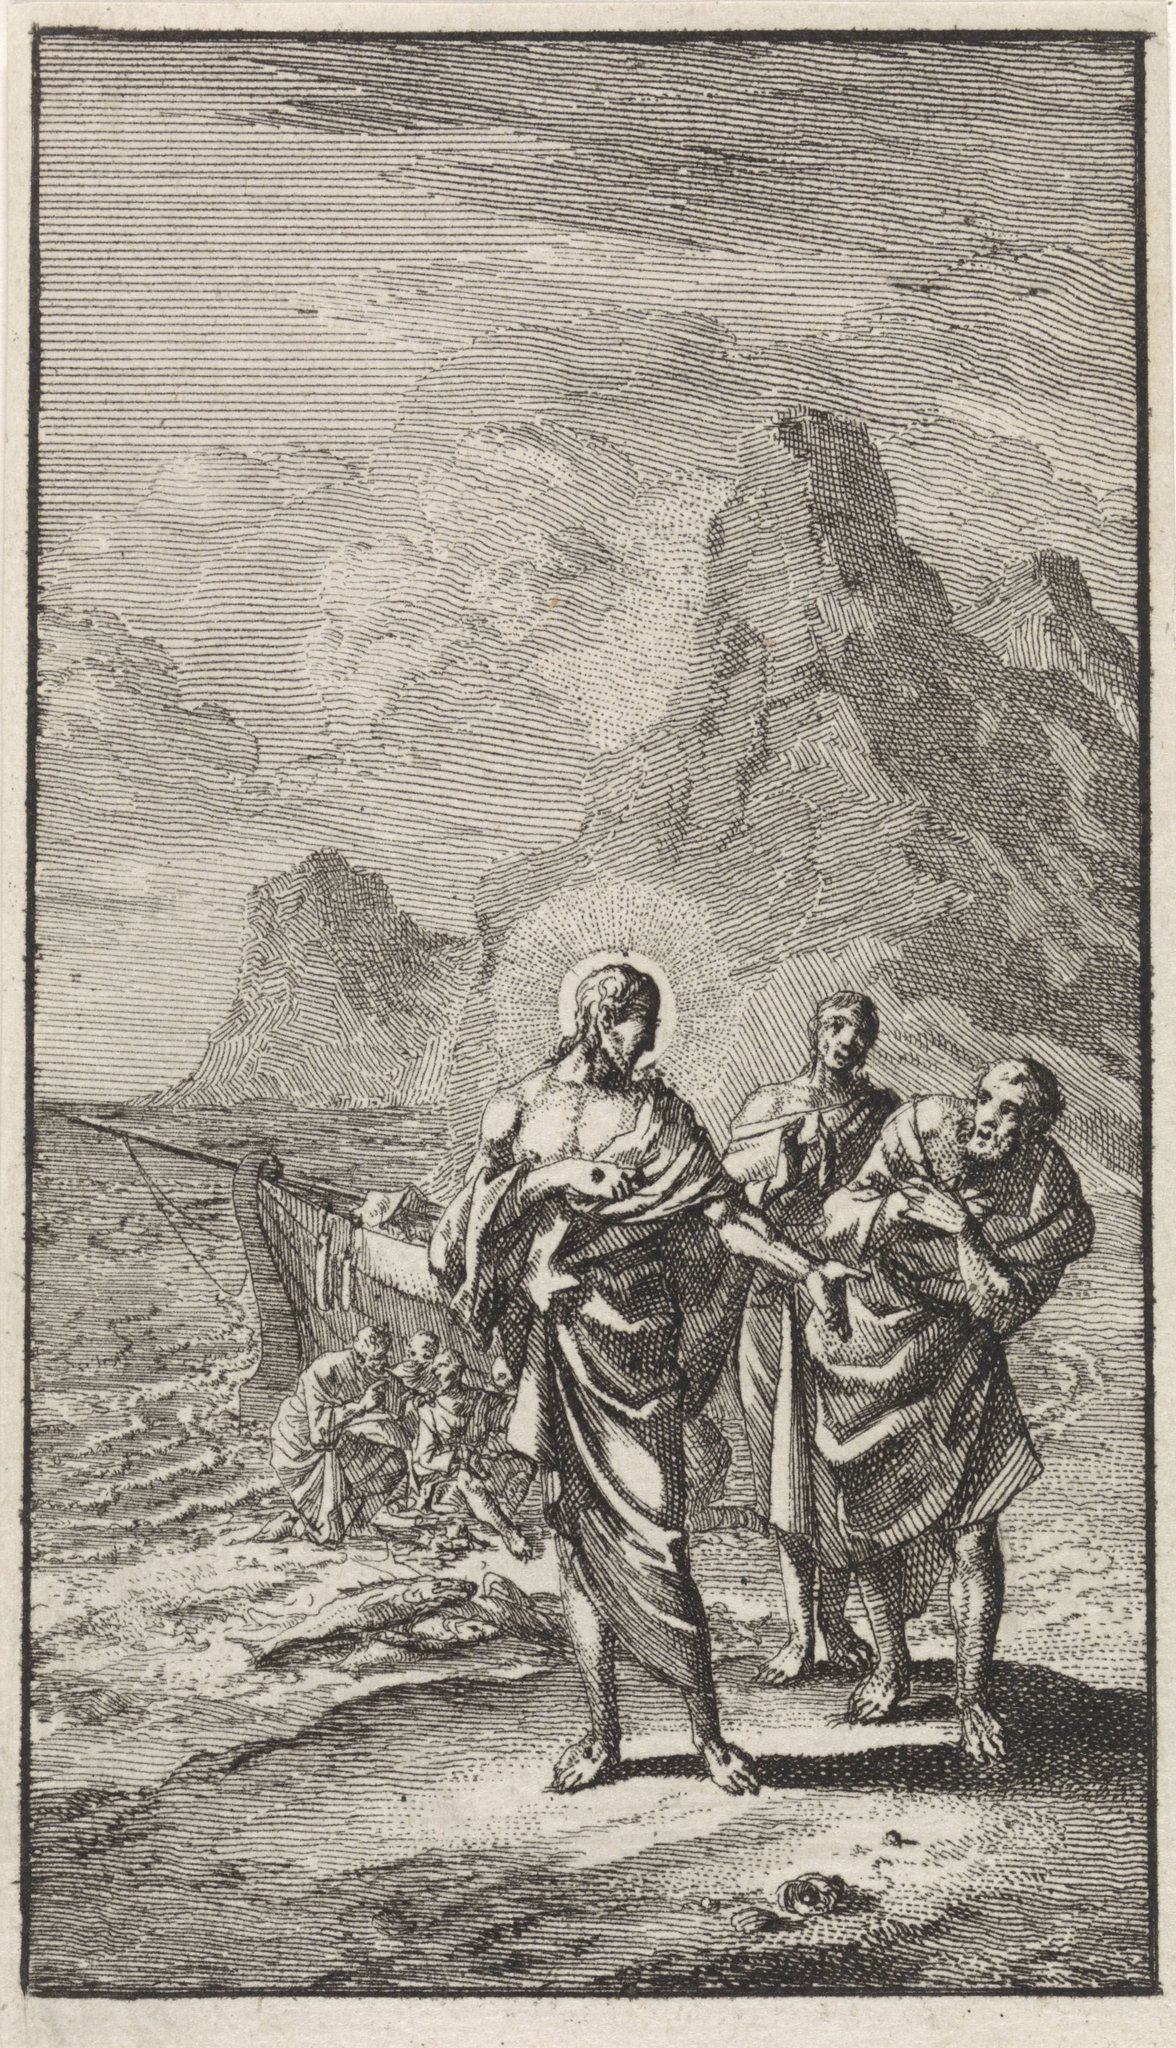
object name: print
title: Christus verschijnt bij het Meer van Galilea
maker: jan luyken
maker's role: draughtsman, print maker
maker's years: 1649-1712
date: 1712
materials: paper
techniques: etching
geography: amsterdam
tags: appearance of christ at the lake of gennesaret (sea of galilee, sea of tiberias): miraculous draught of fishes (after the resurrection)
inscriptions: collector's mark: Lugt 2228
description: Proefdruk van illustratie voor: Luyken, Jan. Bybel printen. Amsterdam: Pieter Arentsz. II (wed.) en Cornelis van der Sys, 1712, p. 34.